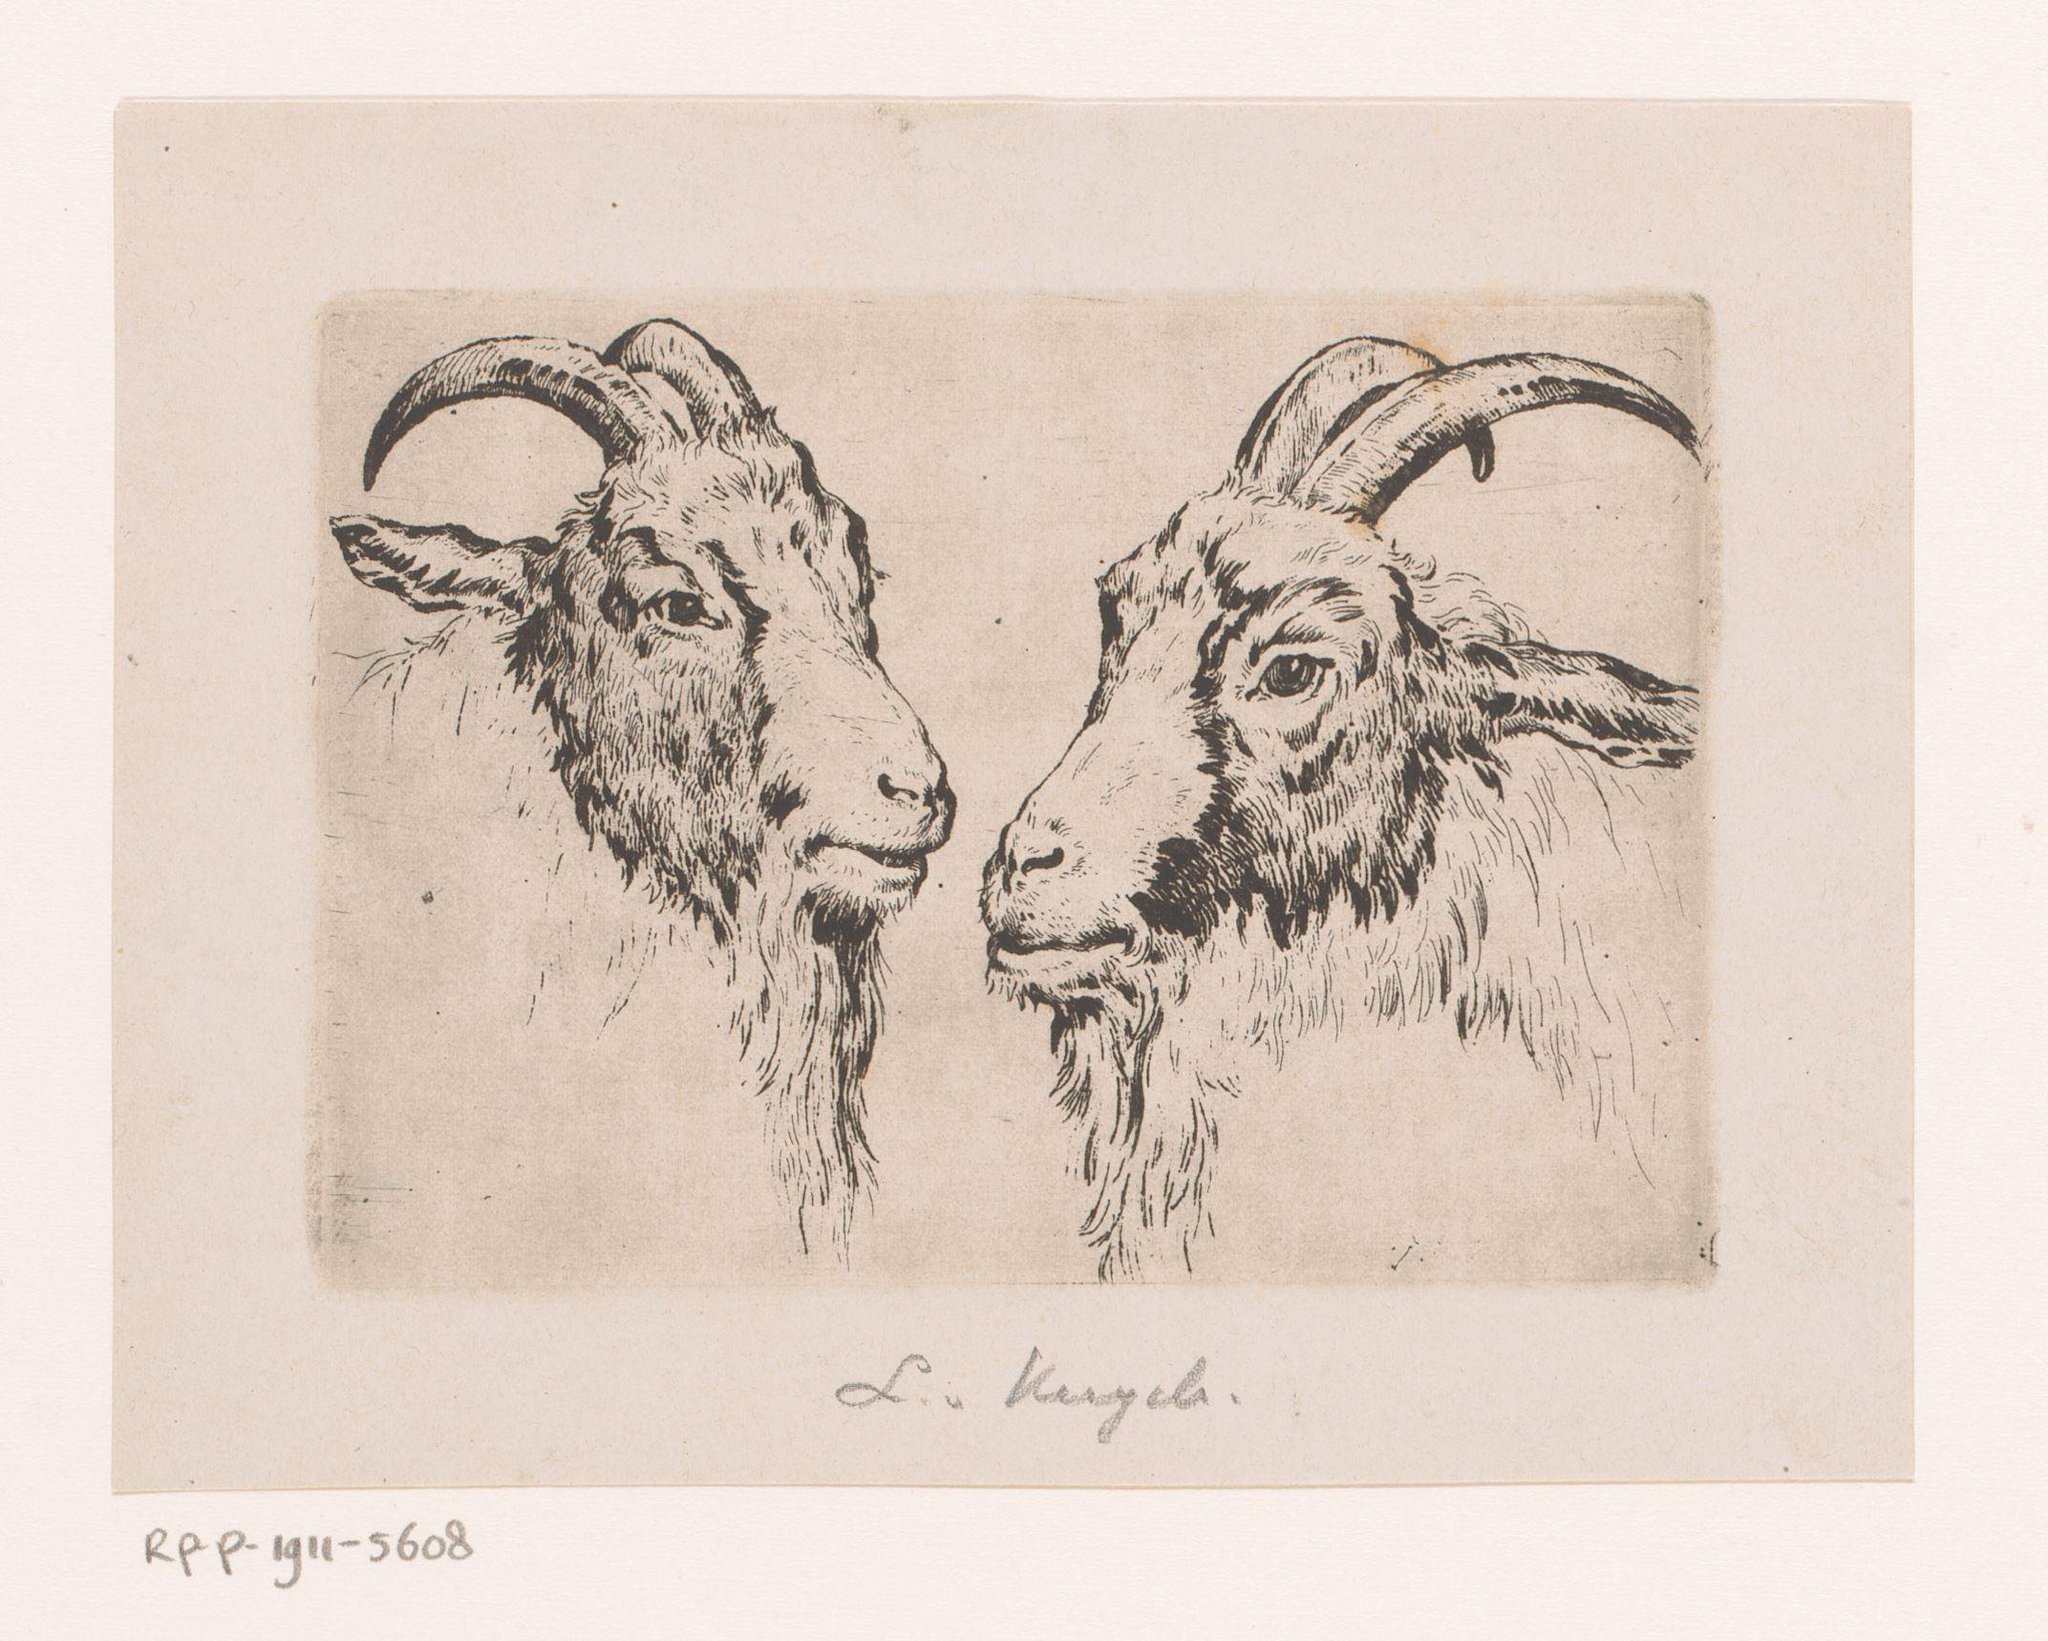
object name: print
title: Twee geitenkoppen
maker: jean louis van kuyck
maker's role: print maker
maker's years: 1821-1871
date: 1862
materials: paper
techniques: etching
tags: goat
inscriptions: collector's mark: Lugt 1485, collector's mark: Lugt 2228